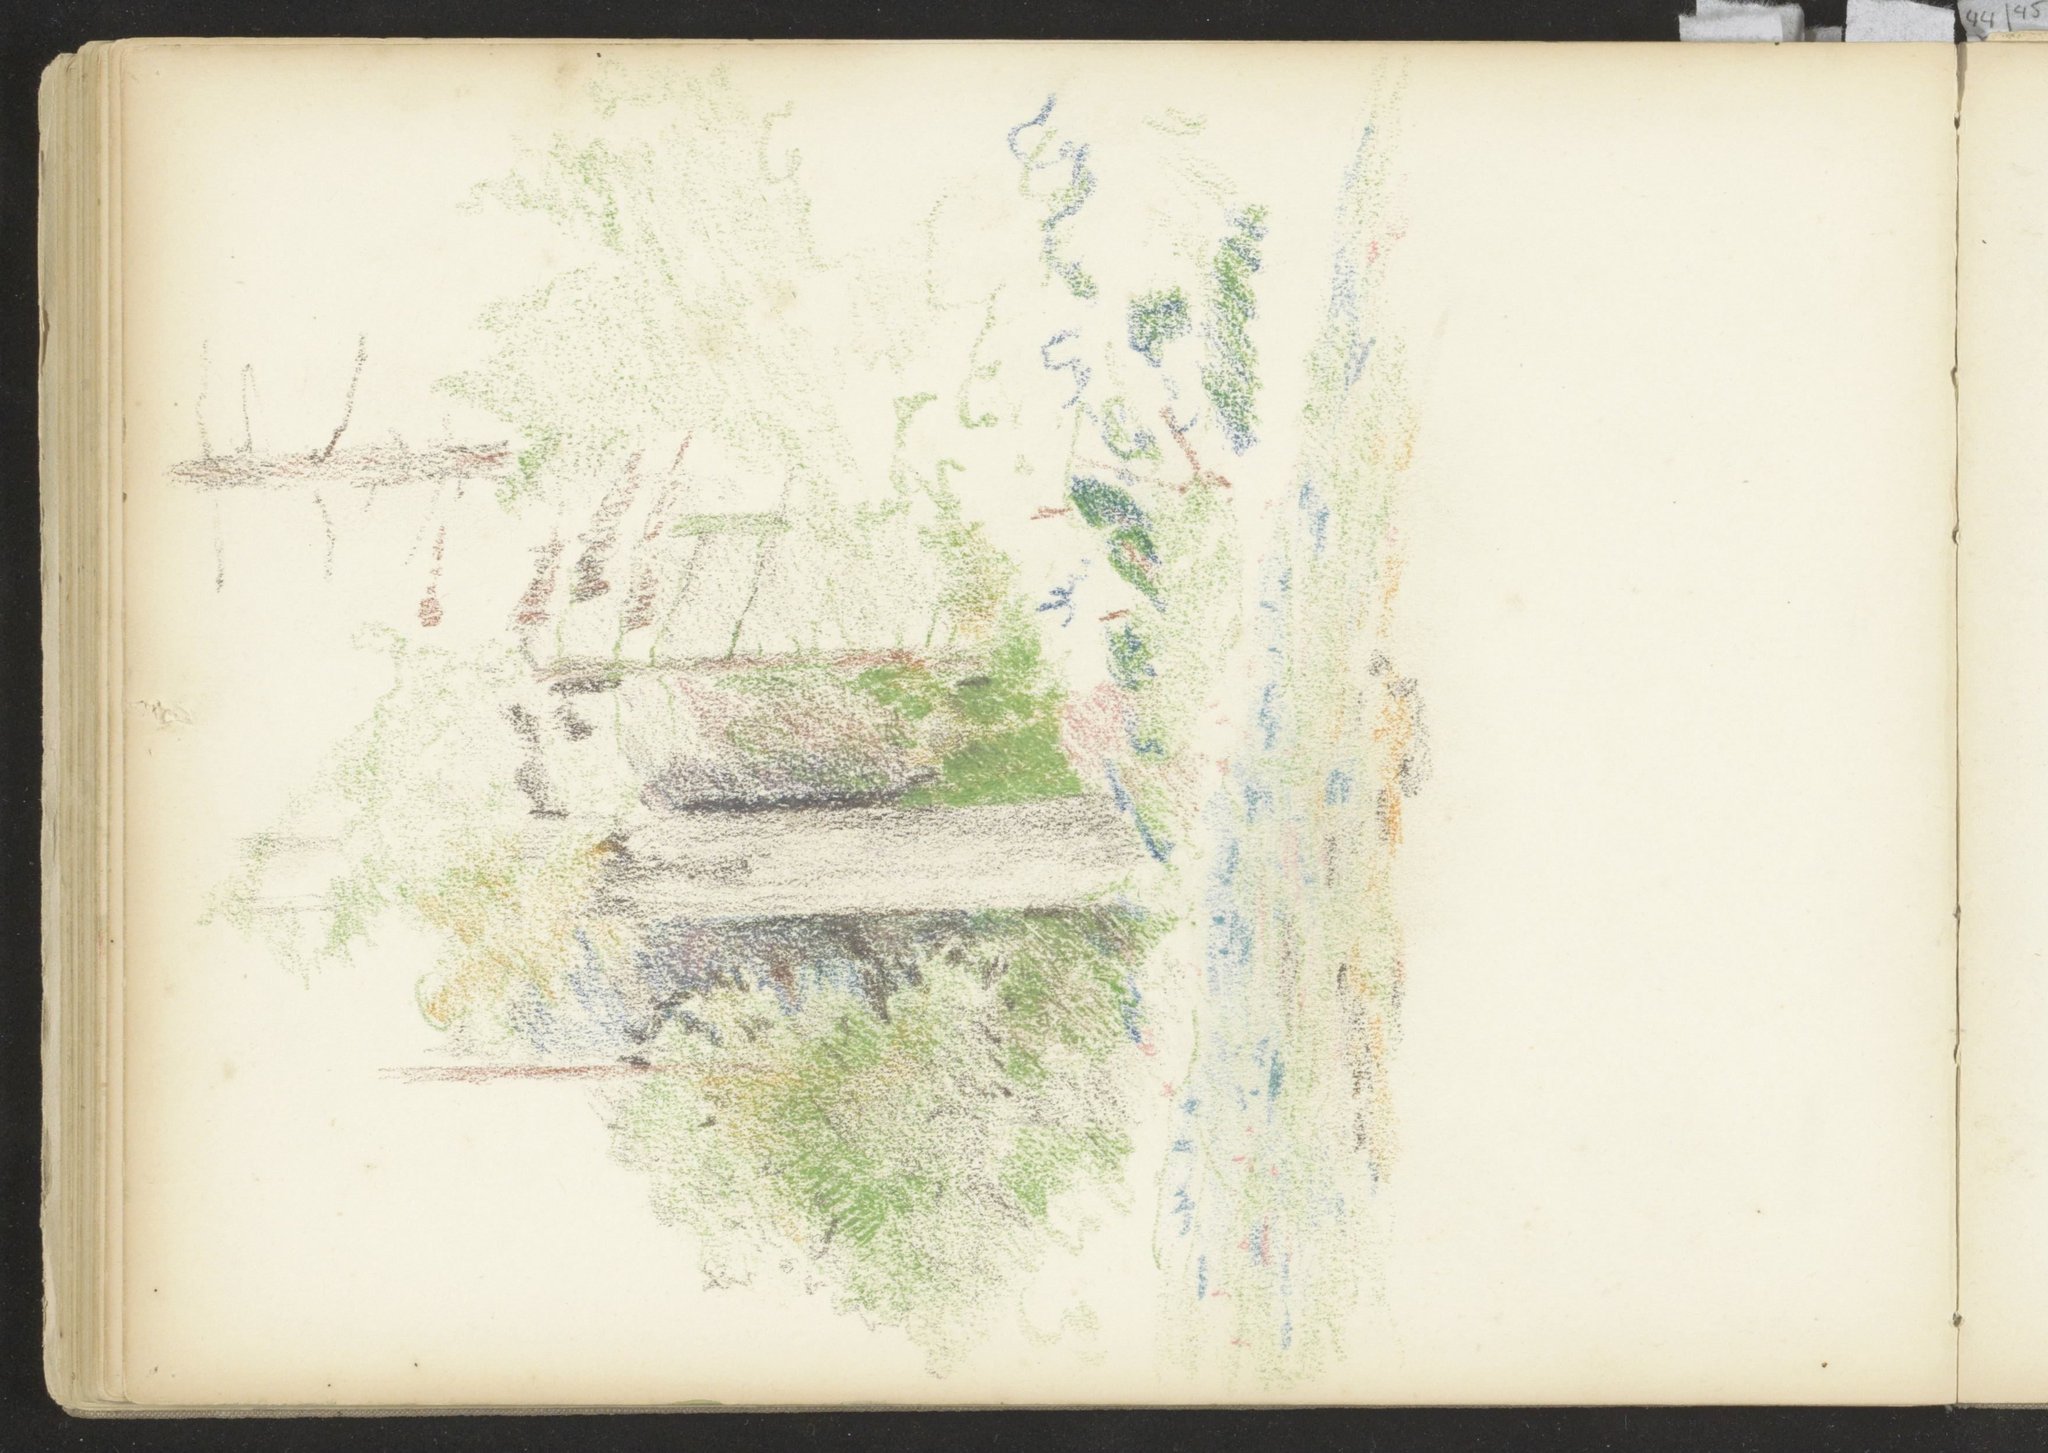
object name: sketchbook leaf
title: Rand van een bos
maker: jonkheer johannes ludovicus paulus bosch van drakestein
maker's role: draughtsman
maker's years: 1865-1929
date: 1913-1916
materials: chalk, paper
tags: fringe, edge of the wood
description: Blad 40 verso uit een schetsboek met 47 bladen.